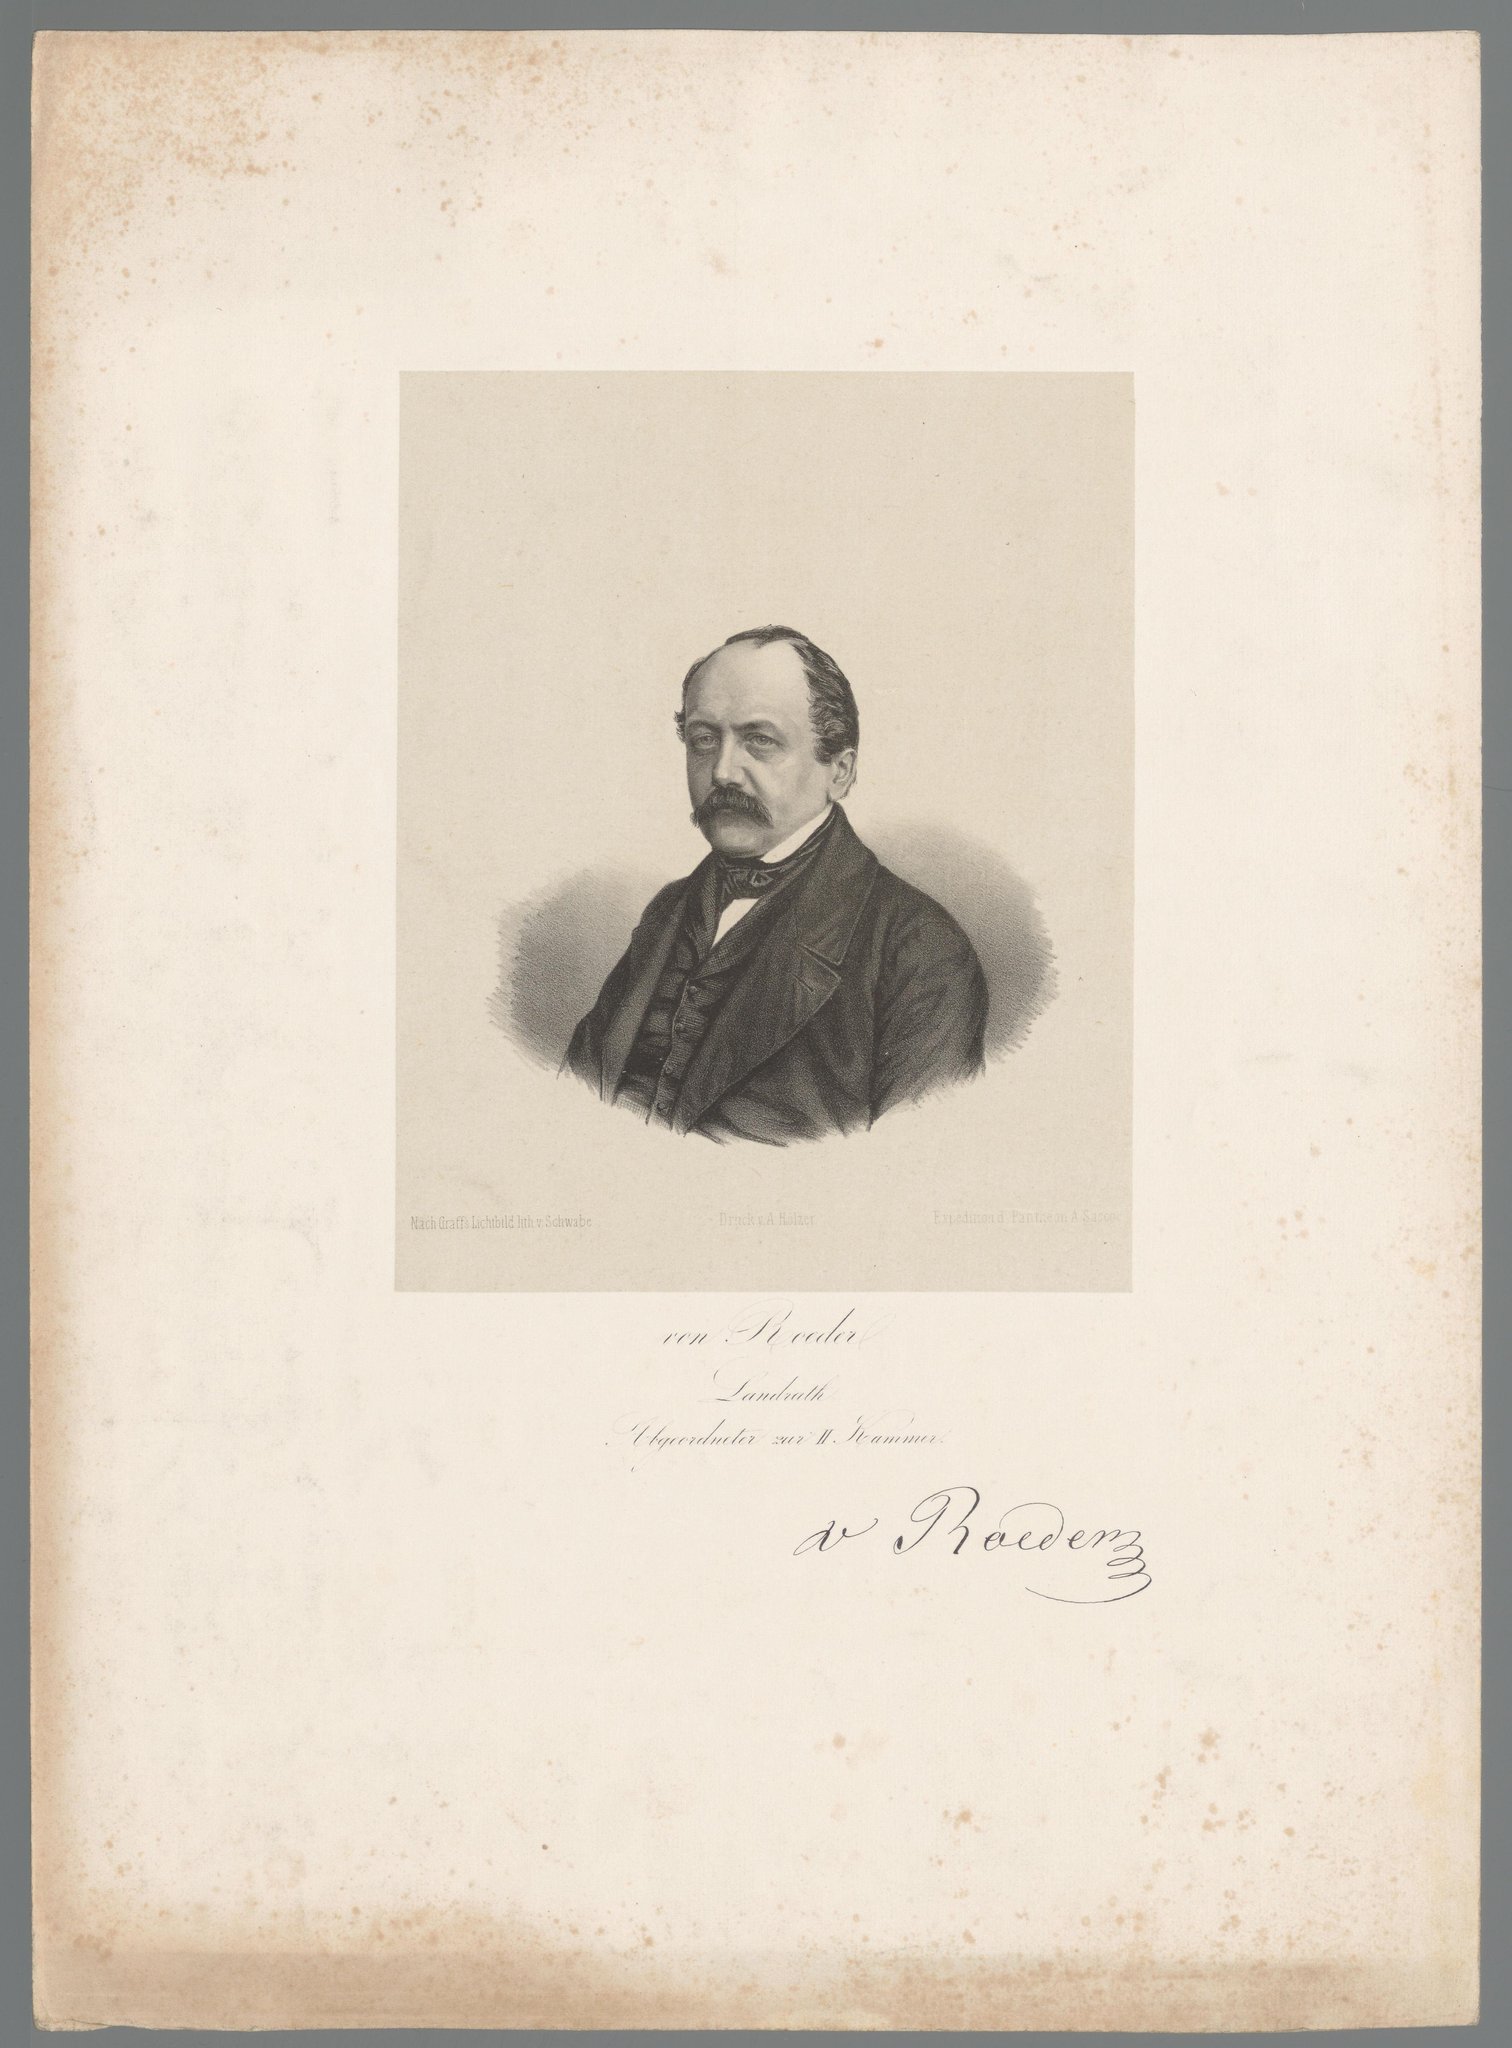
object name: print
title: Expedition des Pantheon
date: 1830-1860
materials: paper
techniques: lithograph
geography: berlin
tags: moustache, adult man, historical persons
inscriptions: collector's mark: Lugt 2228